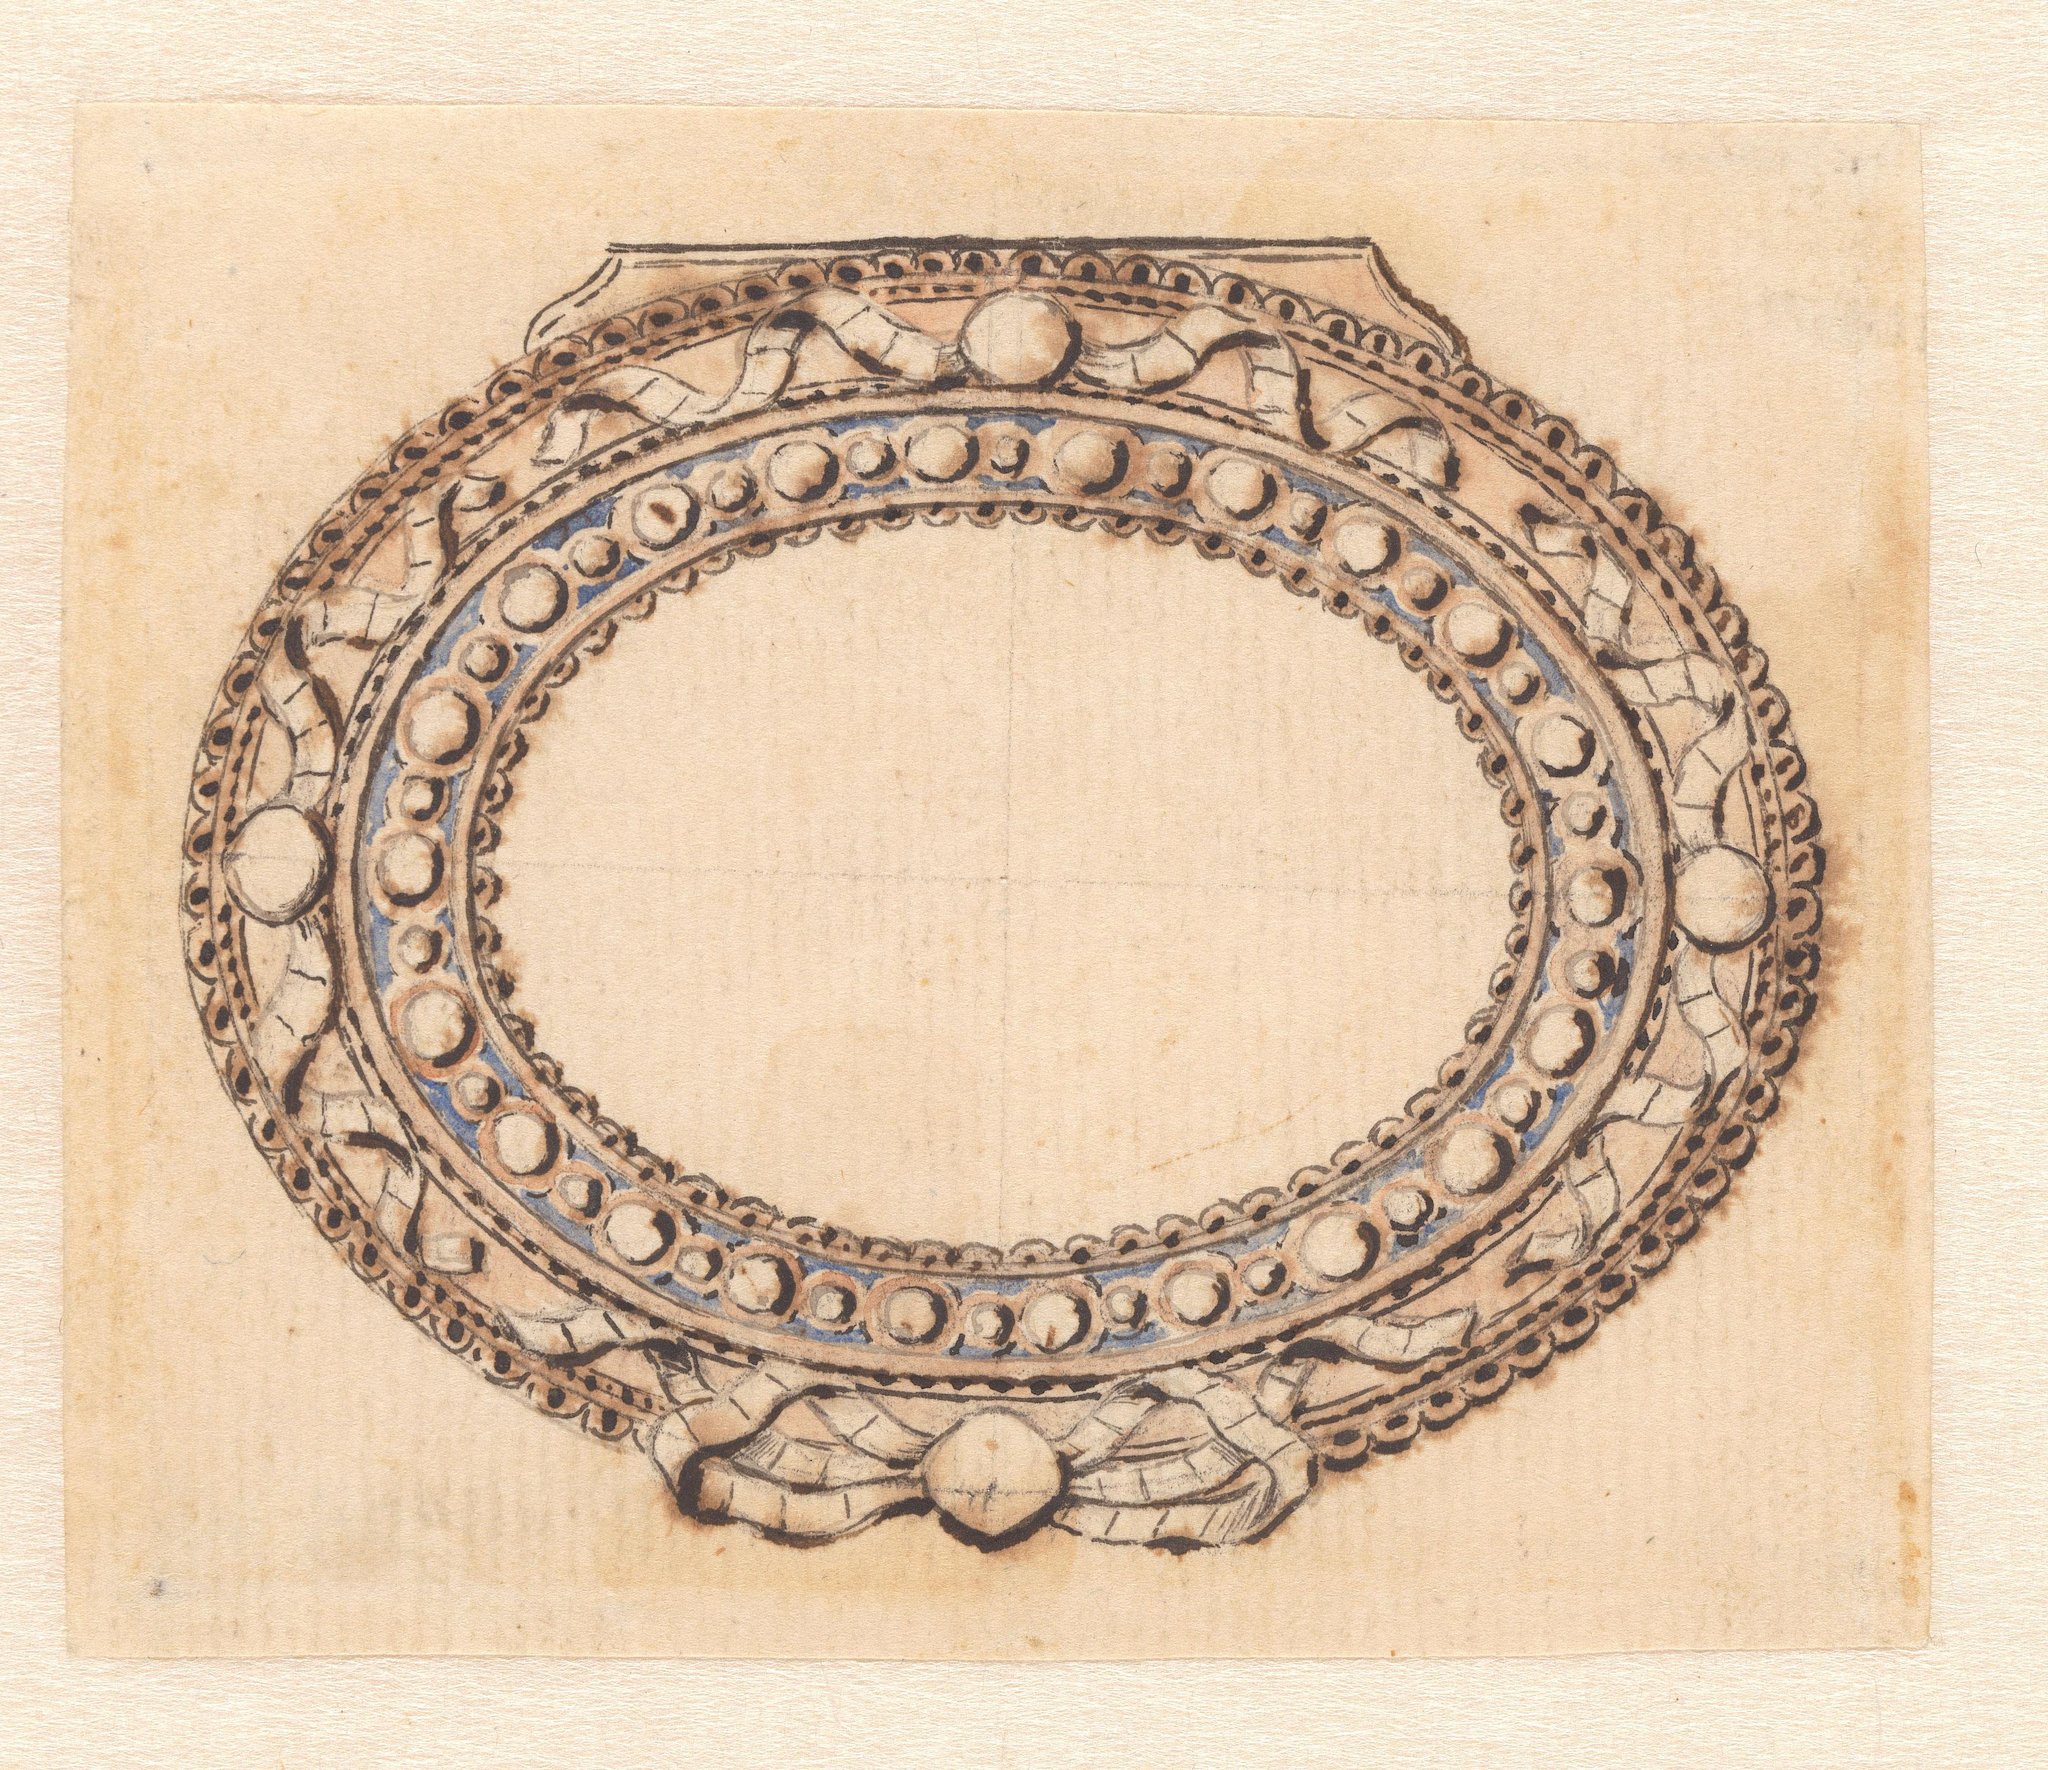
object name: design drawing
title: Snuifdoos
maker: Anonymous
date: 1765-1775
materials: graphite, ink, paper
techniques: brush, pen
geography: paris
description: Ontwerp voor het deksel van een ovale snuifdoos, met een leeg ovaal veld omgeven door diamanten.